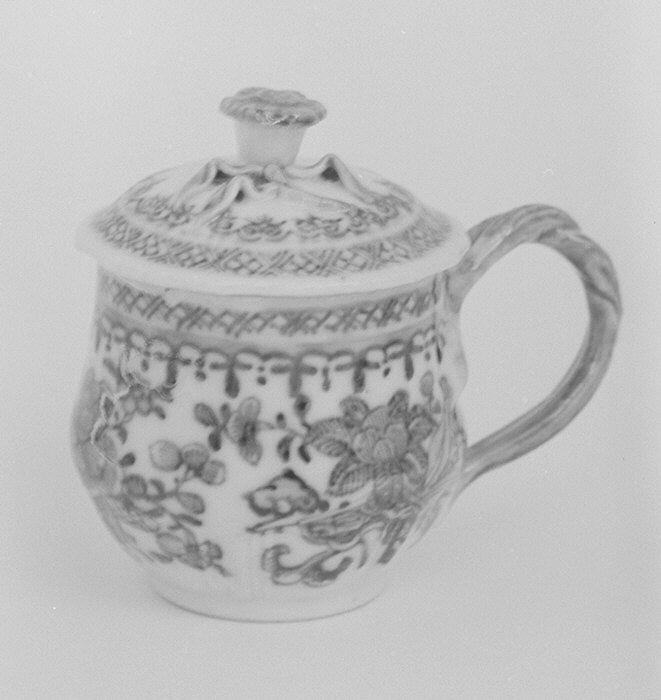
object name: custard cup with cover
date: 1767-1833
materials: hard paste porcelain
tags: flowers